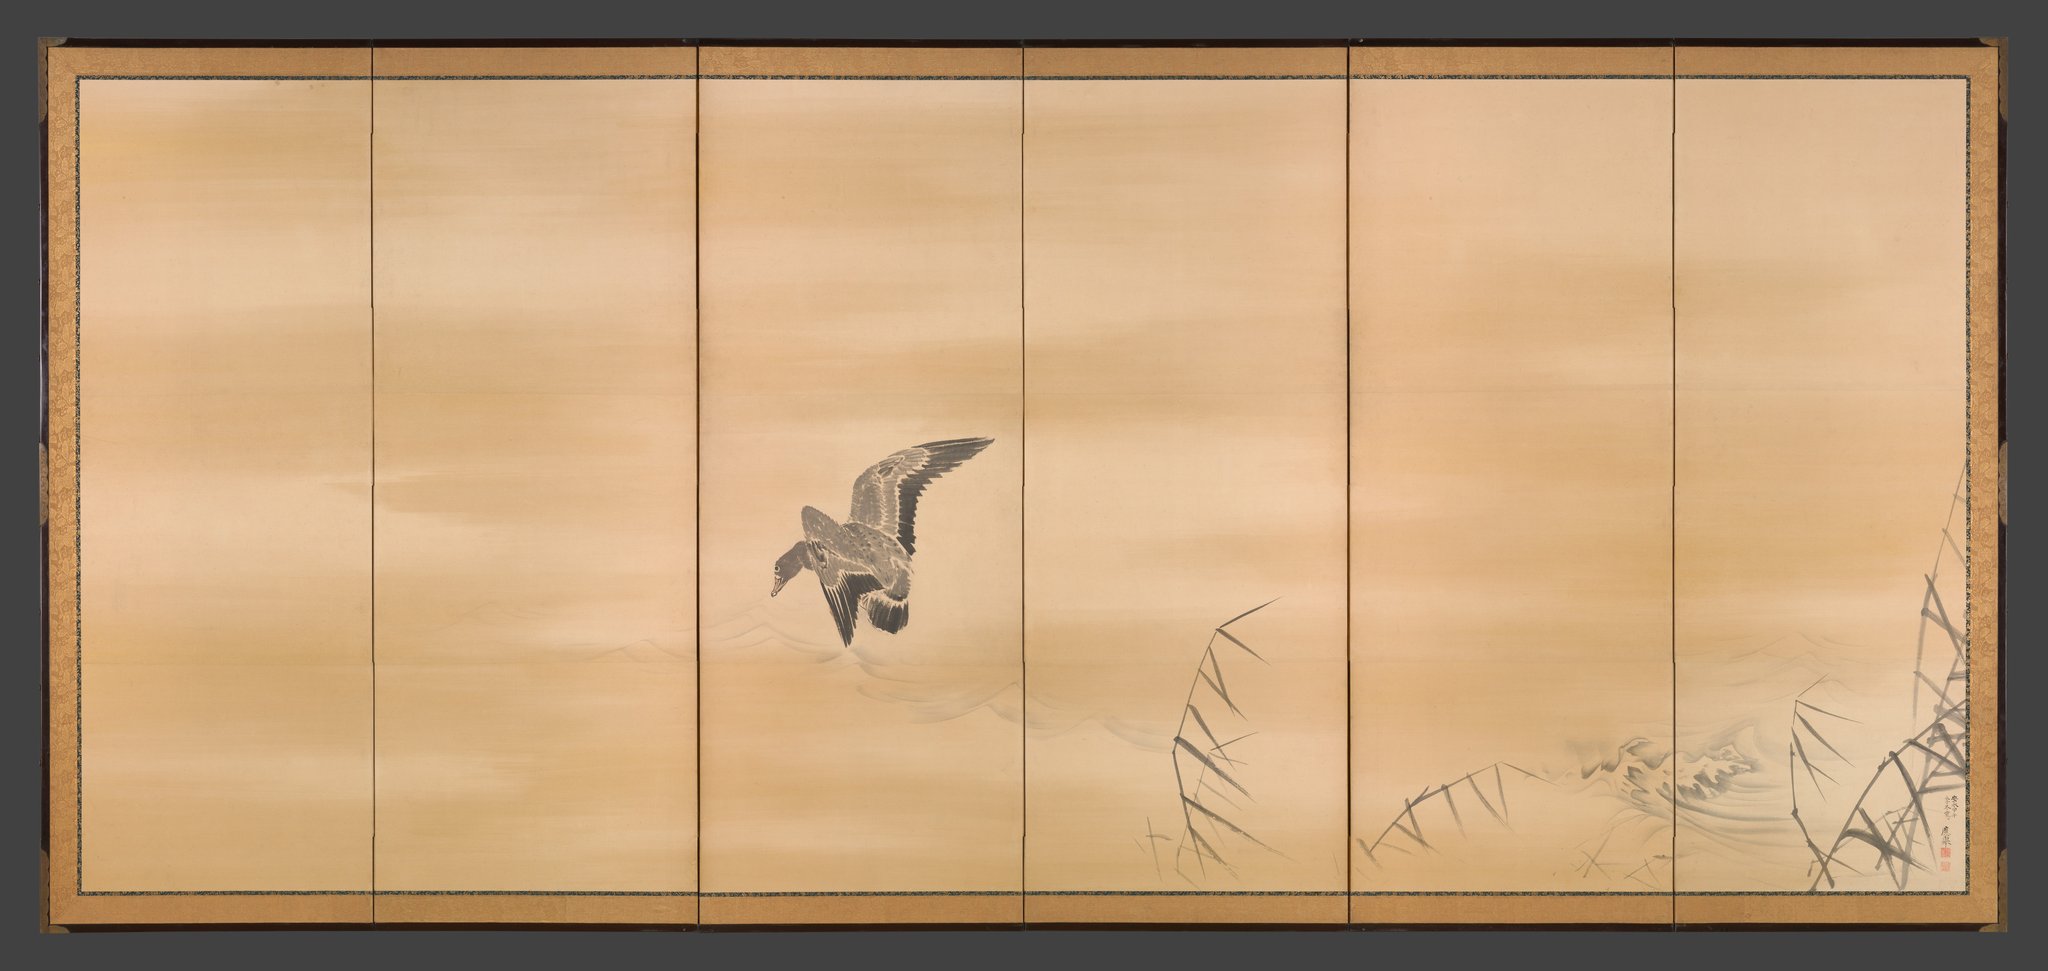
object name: screen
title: Goose and Reeds; Willows in the Moonlight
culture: japanese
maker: maruyama ōkyo 円山応挙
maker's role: artist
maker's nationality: japanese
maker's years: 1733-1795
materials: gold, ink, panel, paper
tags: birds